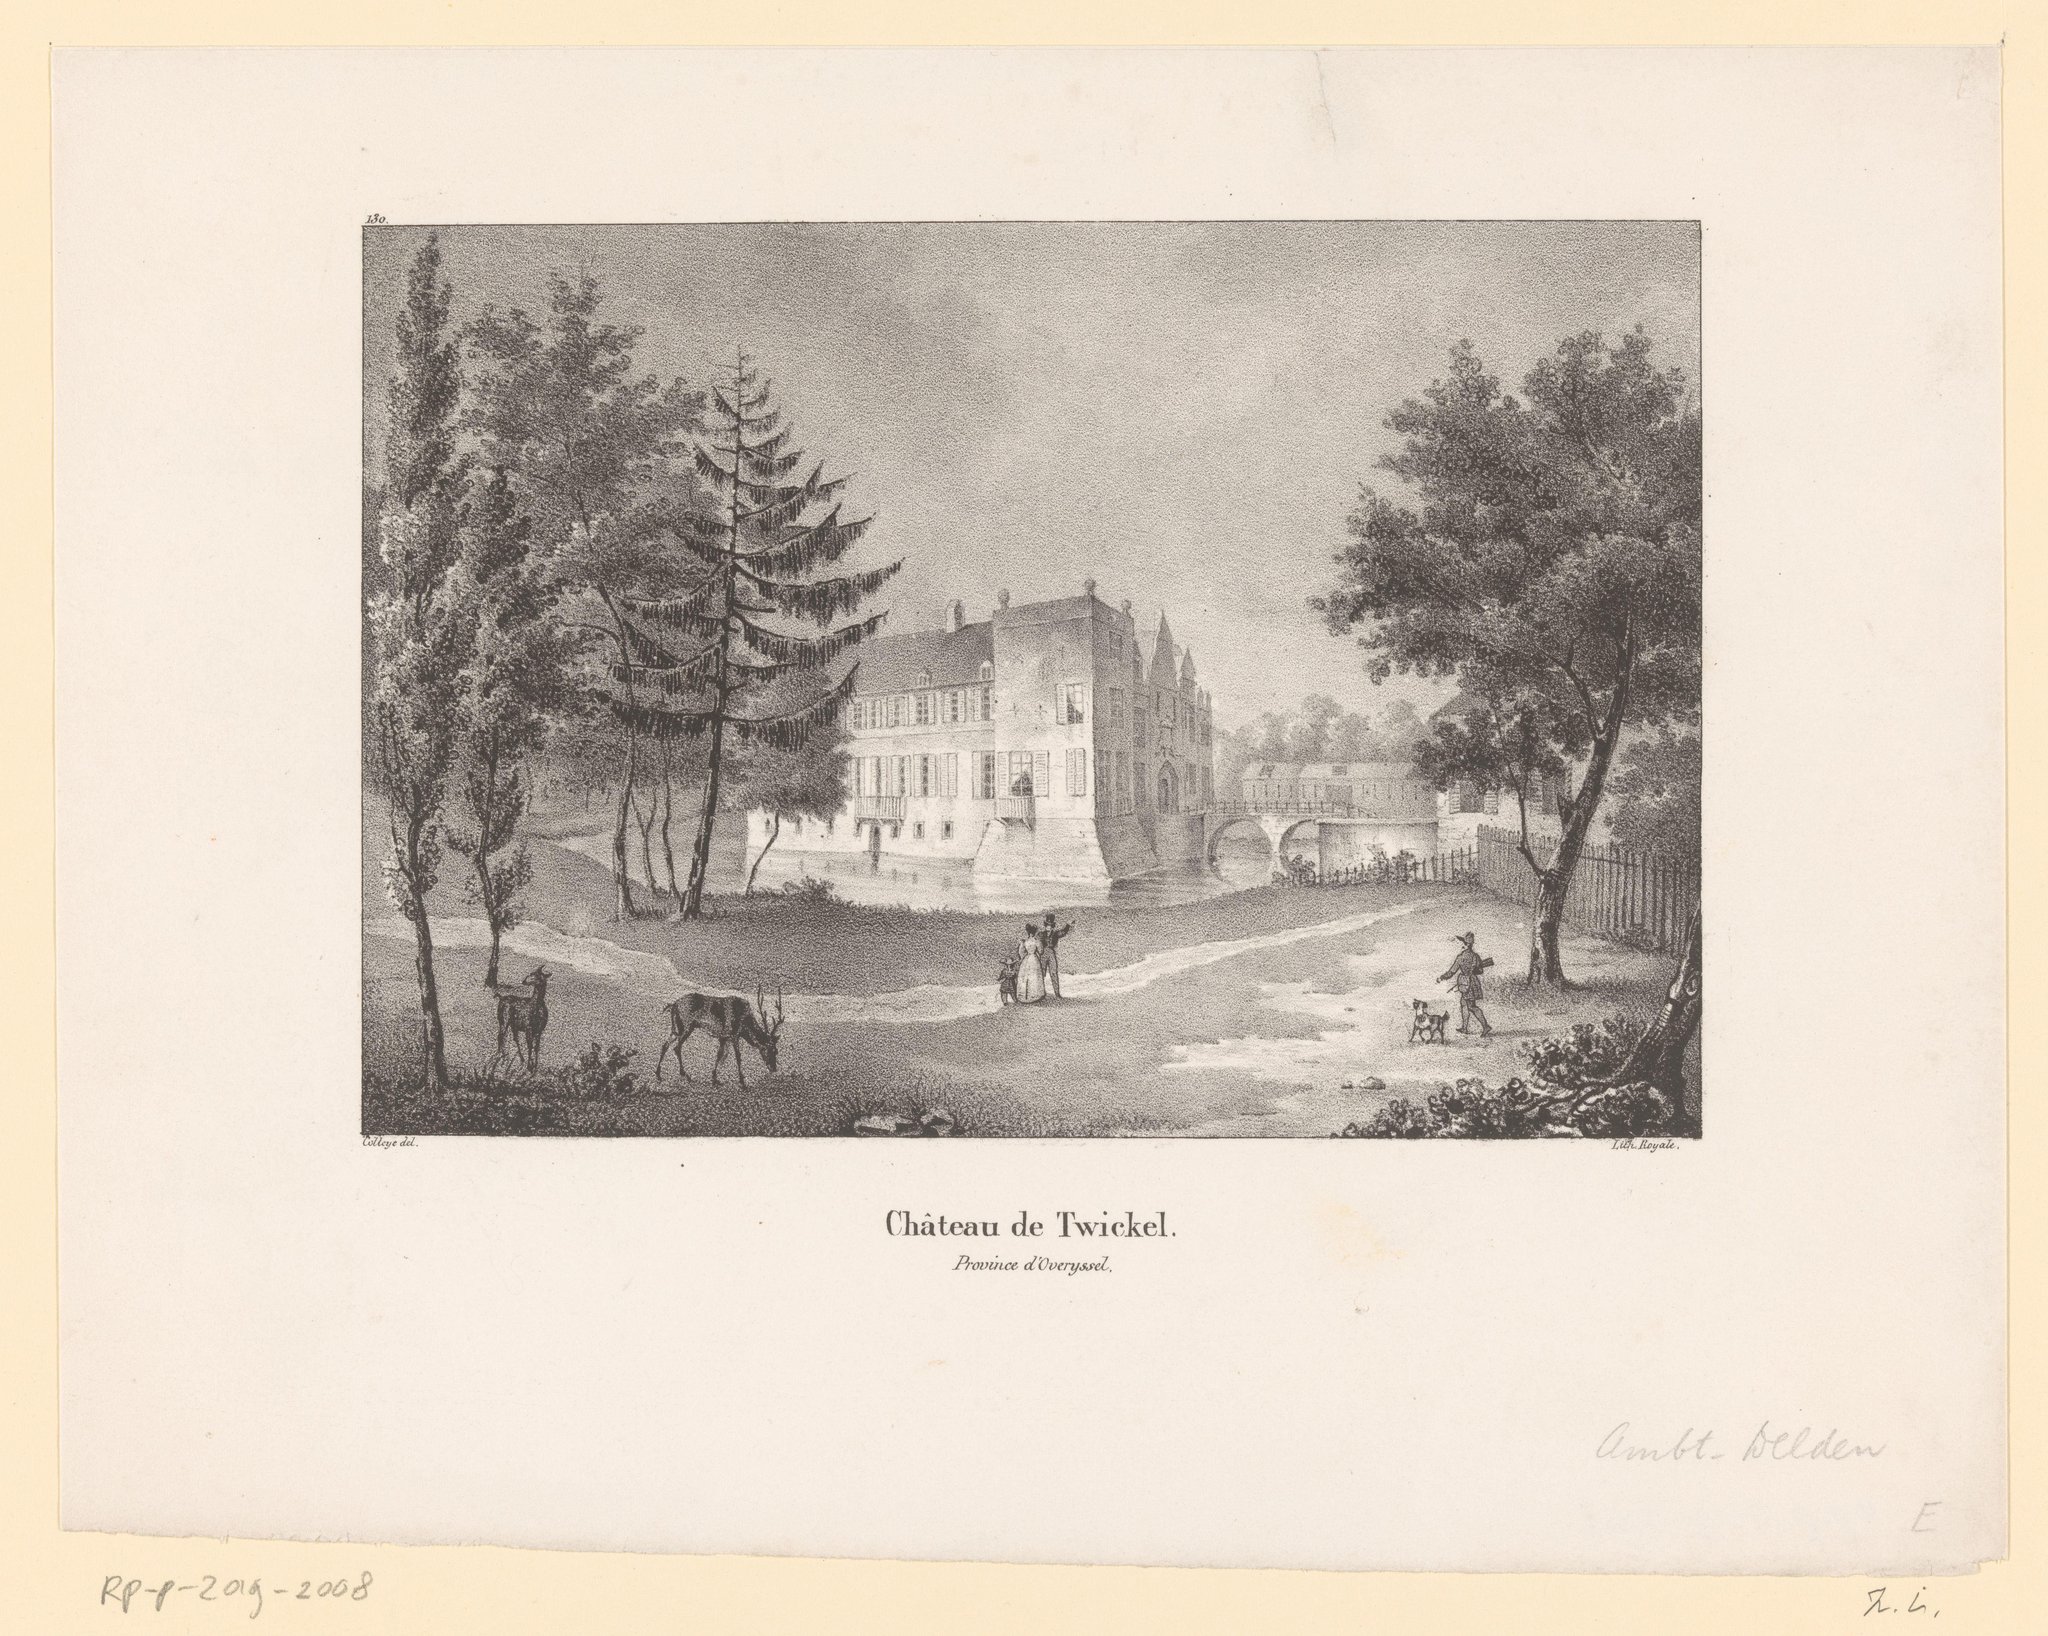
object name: print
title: Gezicht op Kasteel Twickel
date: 1825-1827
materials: paper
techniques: lithograph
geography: brussels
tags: castle, landscape with tower or castle (+ city(-scape) with figures, staffage)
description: Prent mogelijk uit: Cloet, J.J. de. Chateaux et Monumens des Pays-Bas Faisant suite au Voyage pittoresque. Brussel: J.B.A.M. Jobard, [ca. 1825-1827].